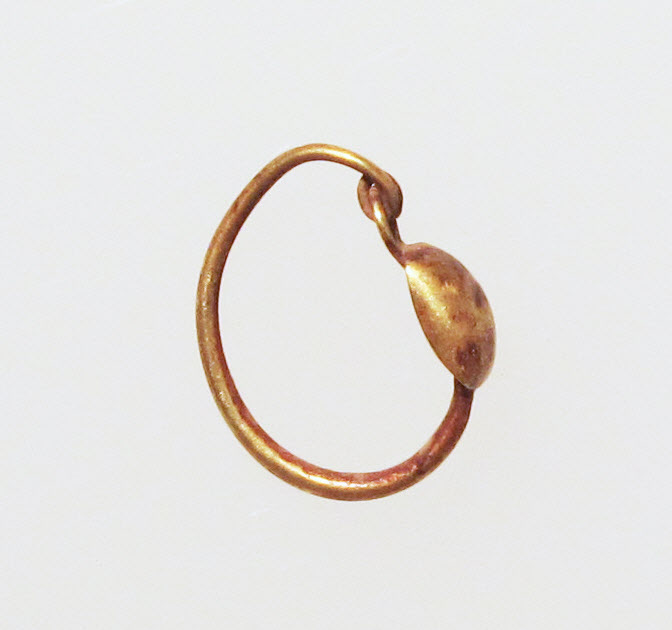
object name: earring with plain loop and disc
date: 7000 BCE-330 CE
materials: gold